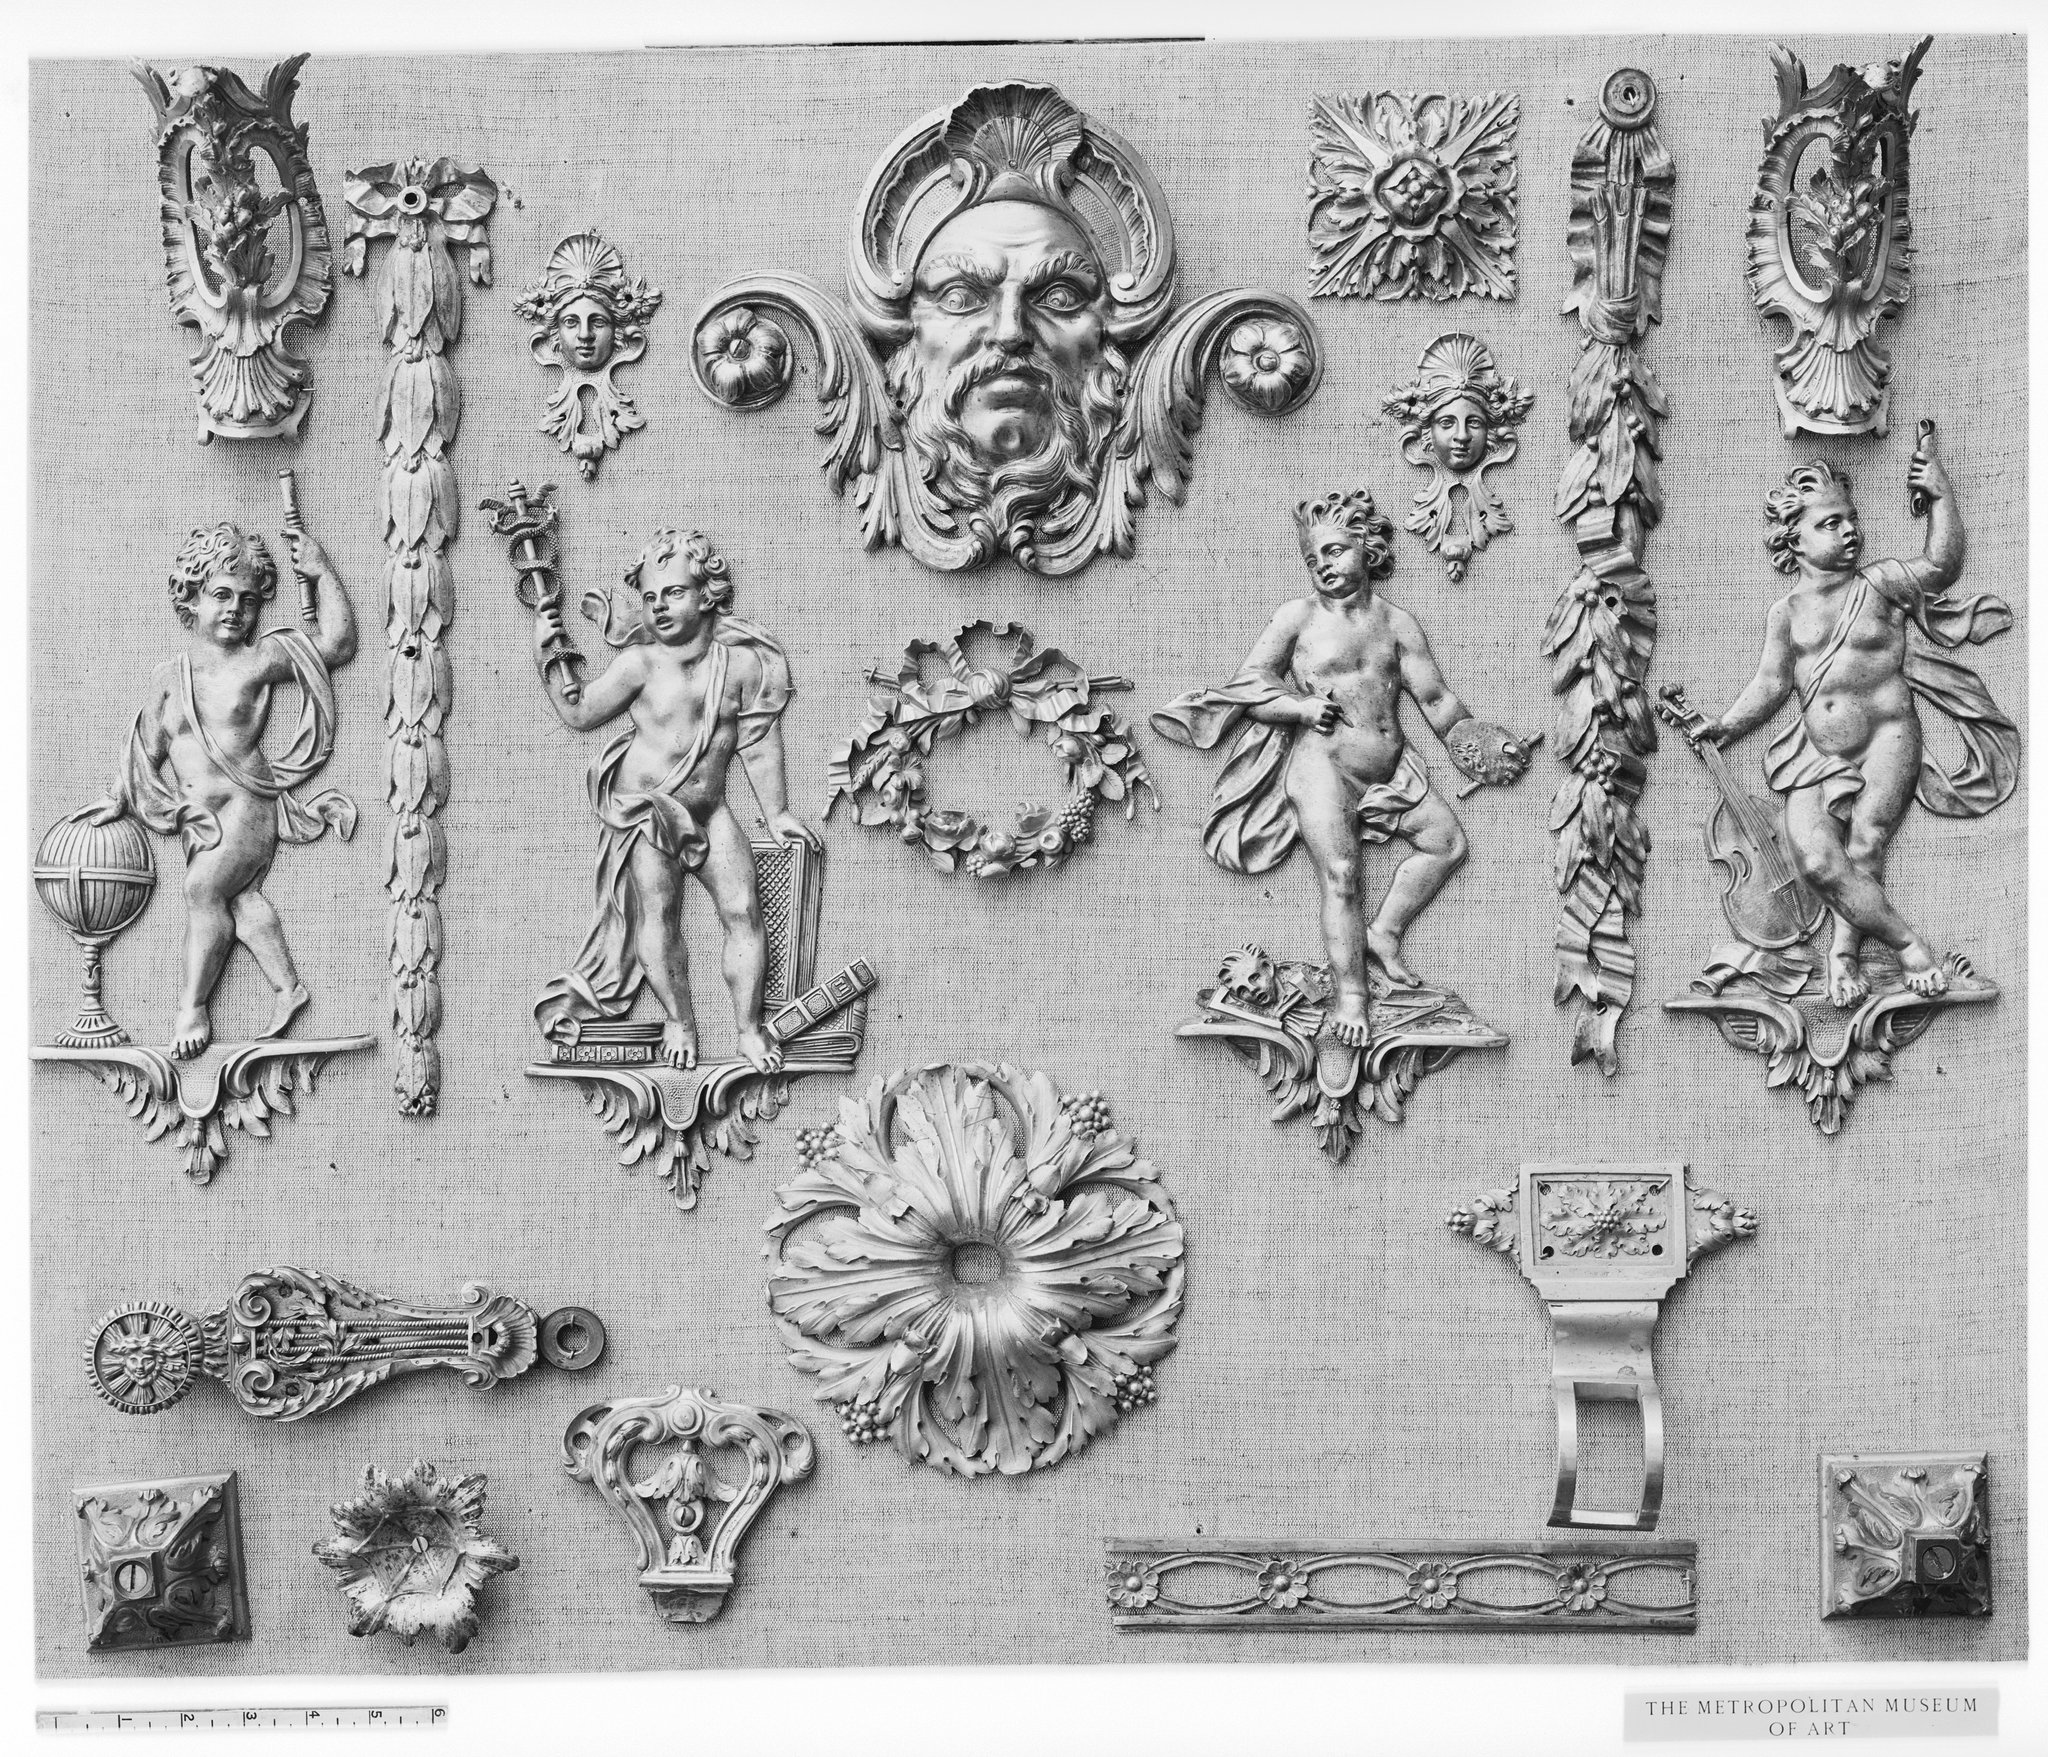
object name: keyhole escutcheon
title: Set of three keyhole escutcheons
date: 1601-1800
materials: gilt bronze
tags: human figures,faces